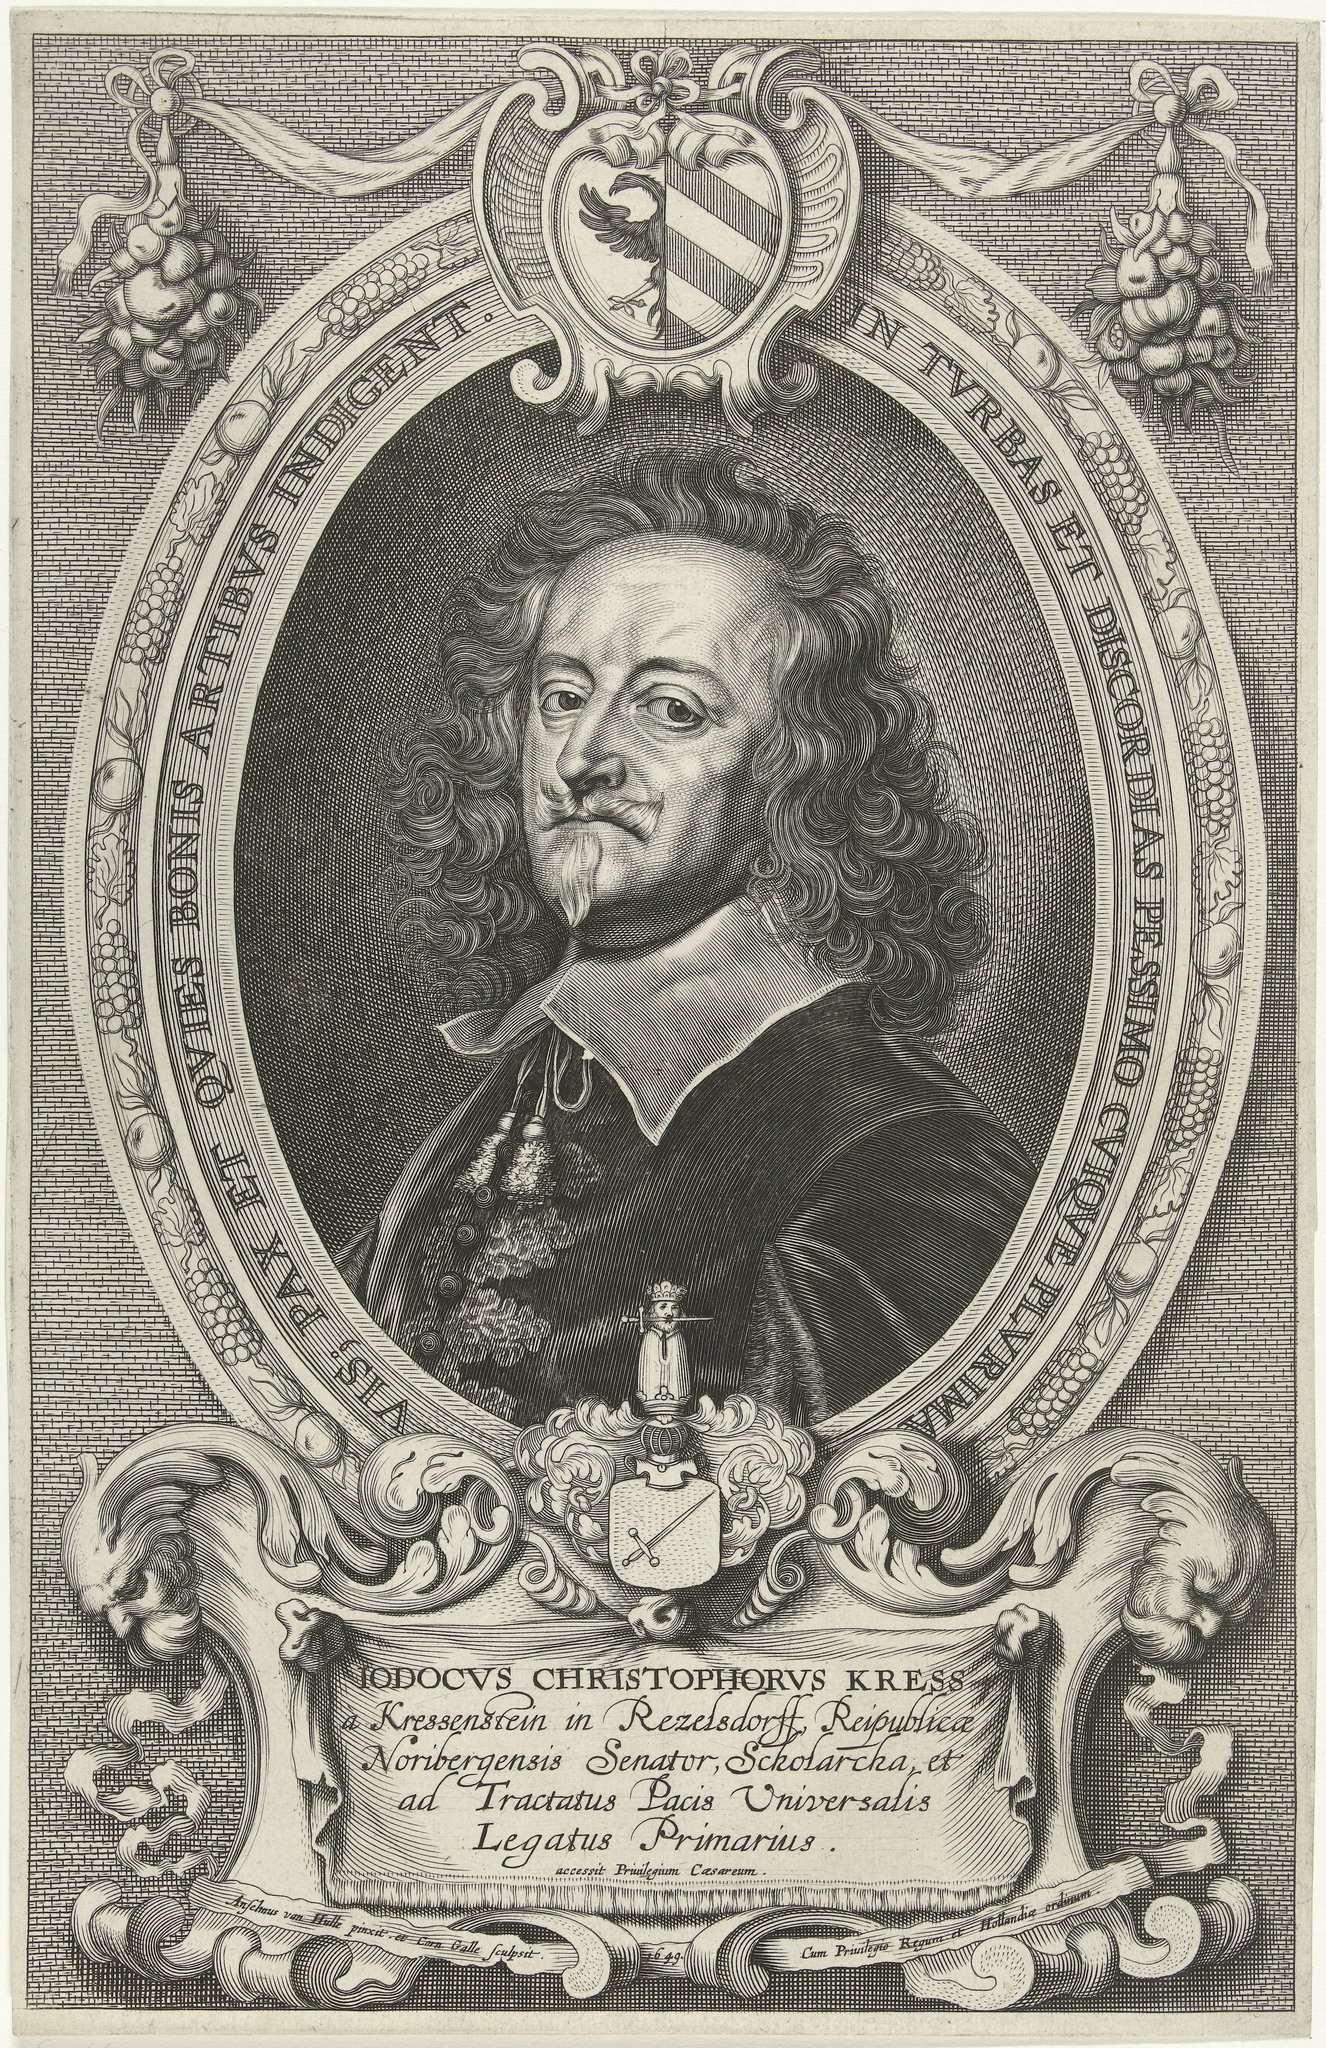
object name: print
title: Celeberrimi ad pacificandum Christiani nominis orbem legati Monasterium et Osnabrugas (...)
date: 1649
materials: paper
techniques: engraving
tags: diplomaat, raadsheer, afgezant, jobst christoph kress von kressenstein (i)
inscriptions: collector's mark: Lugt 2233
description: Portret van Jobst Christoph Kress von Kressenstein, in ovaal met randschrift. Boven het portret het wapen van Neurenberg, onder het familiewapen van Kress von Kressenstein.